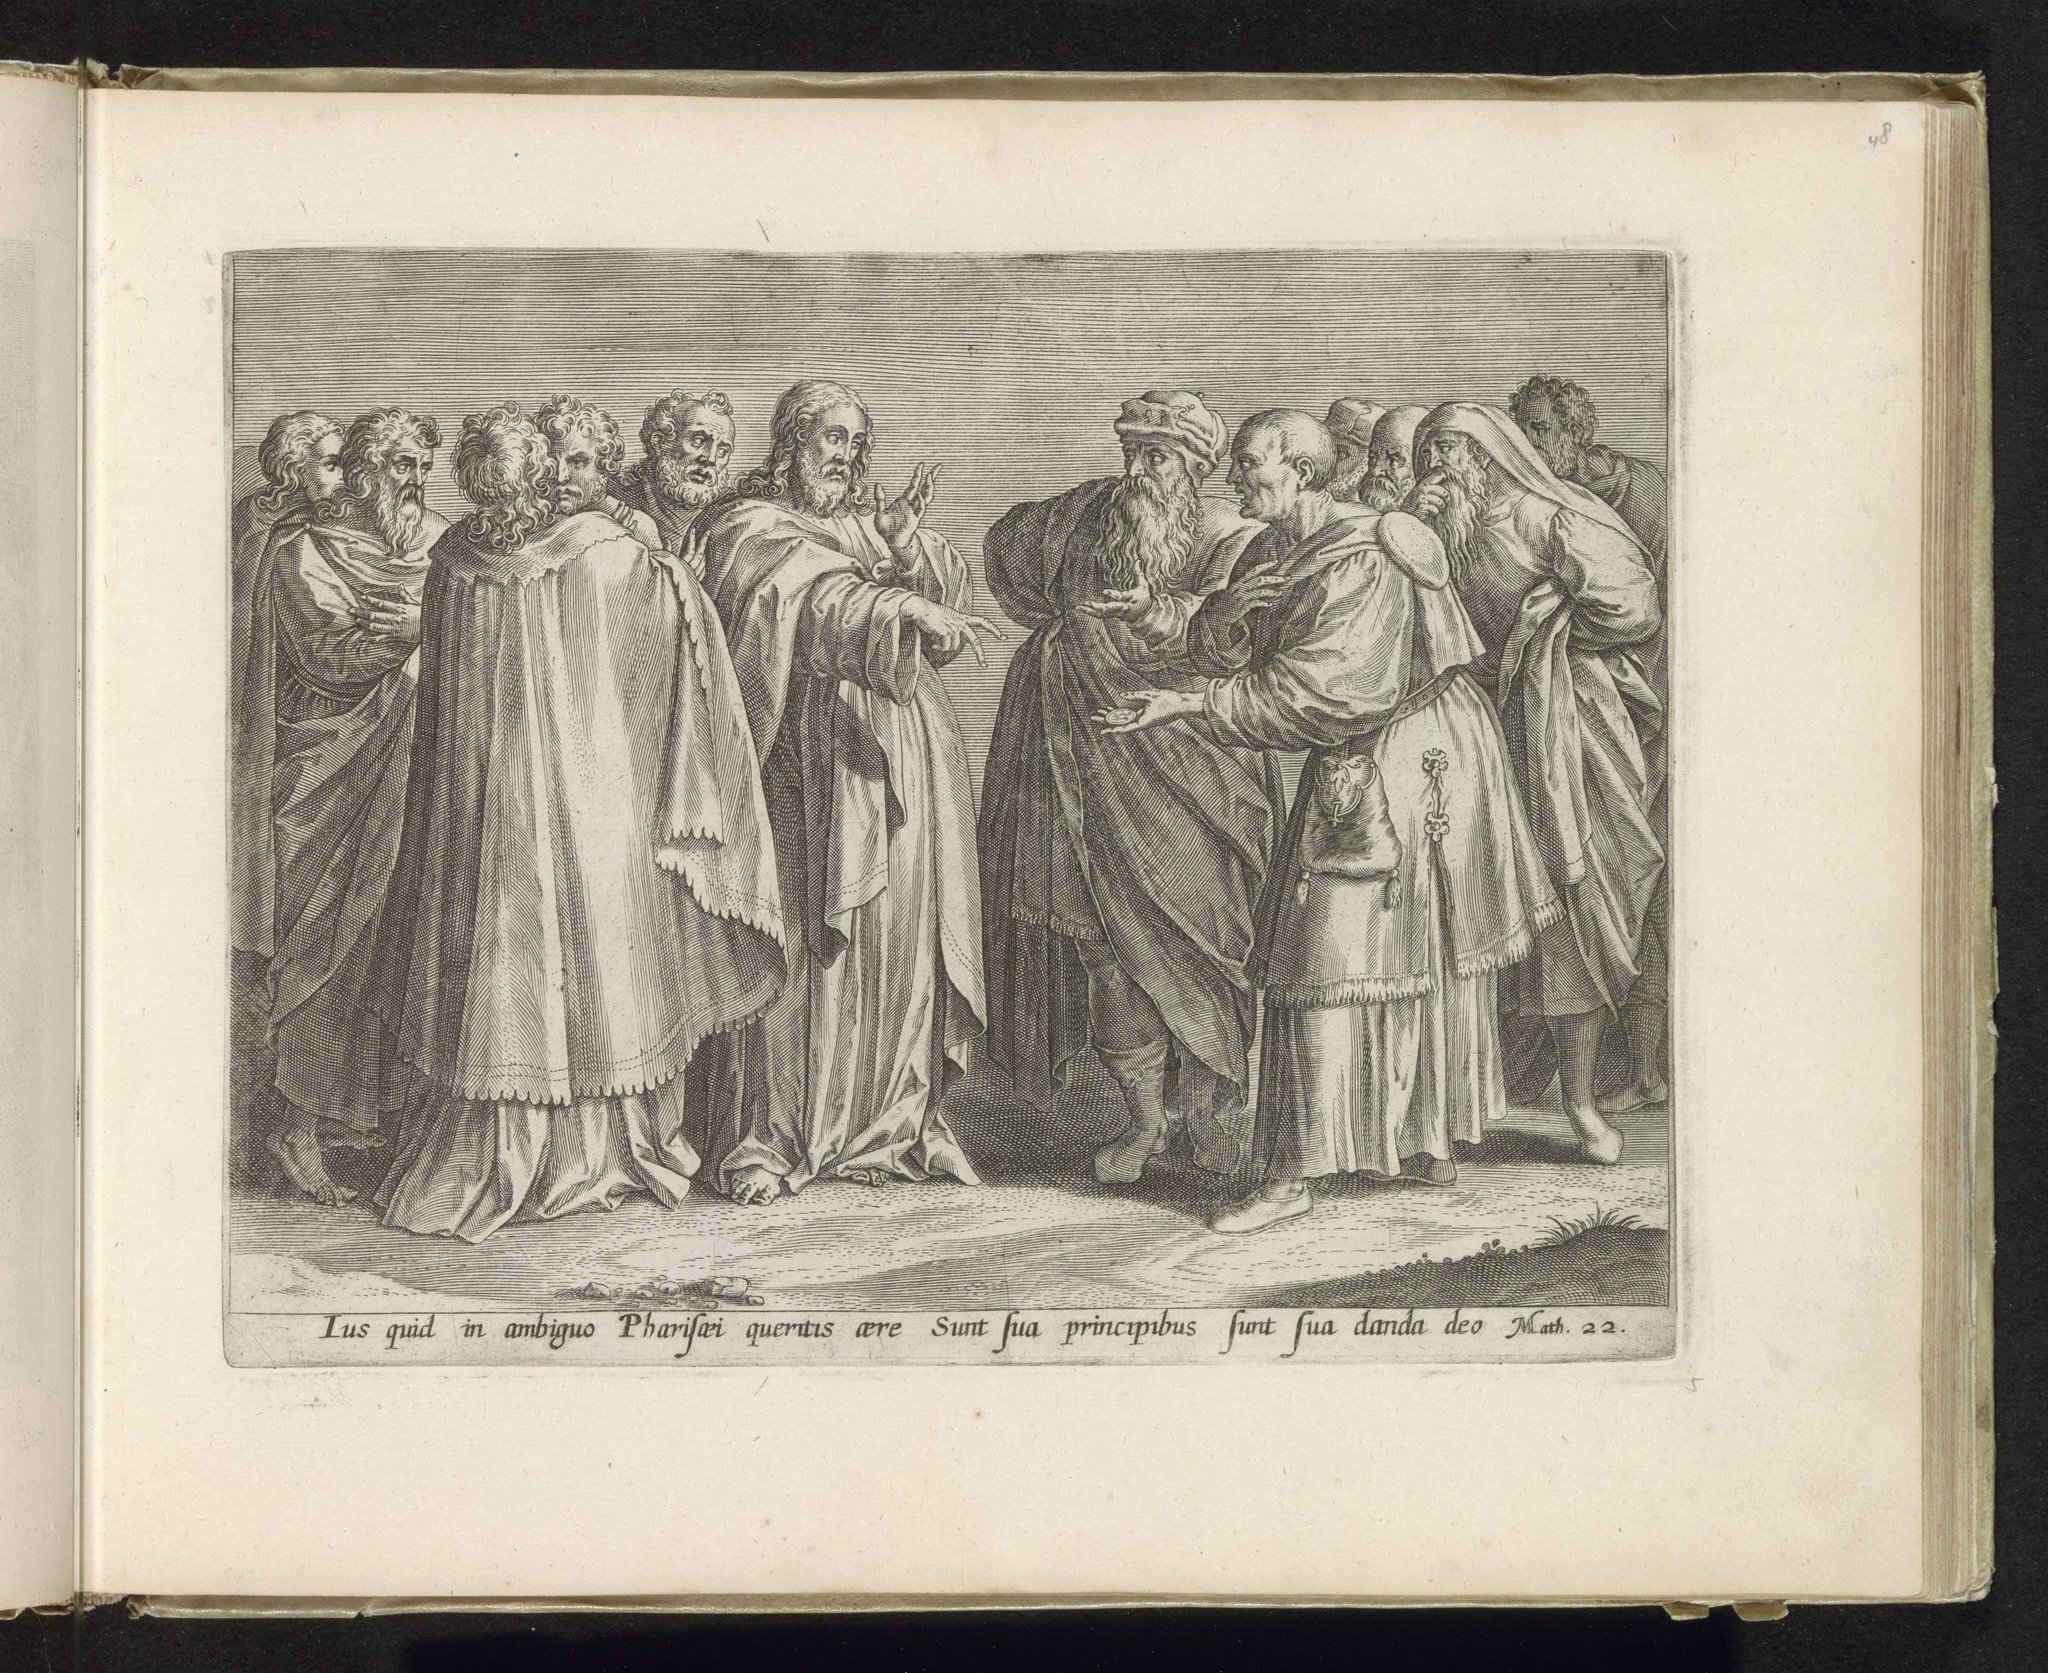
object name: print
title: Christus in debat met de farizeeën over de belasting aan de keizer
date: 1585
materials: paper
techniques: engraving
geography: antwerp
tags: christ (in the temple) in debate with pharisees about the tribute to caesar (matthew 22:15-22; mark 12:13-17; luke 20:20-26)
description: Christus in debat met de farizeeën. Achter hem staan zijn leerlingen. Een van de farizeeën toont hem een munt en vraagt aan Christus of het toegestaan is belasting aan de keizer te betalen. Onder de voorstelling een verwijzing in het Latijn naar de Bijbeltekst in Mat. 22. Deze prent maakt deel uit van een album.